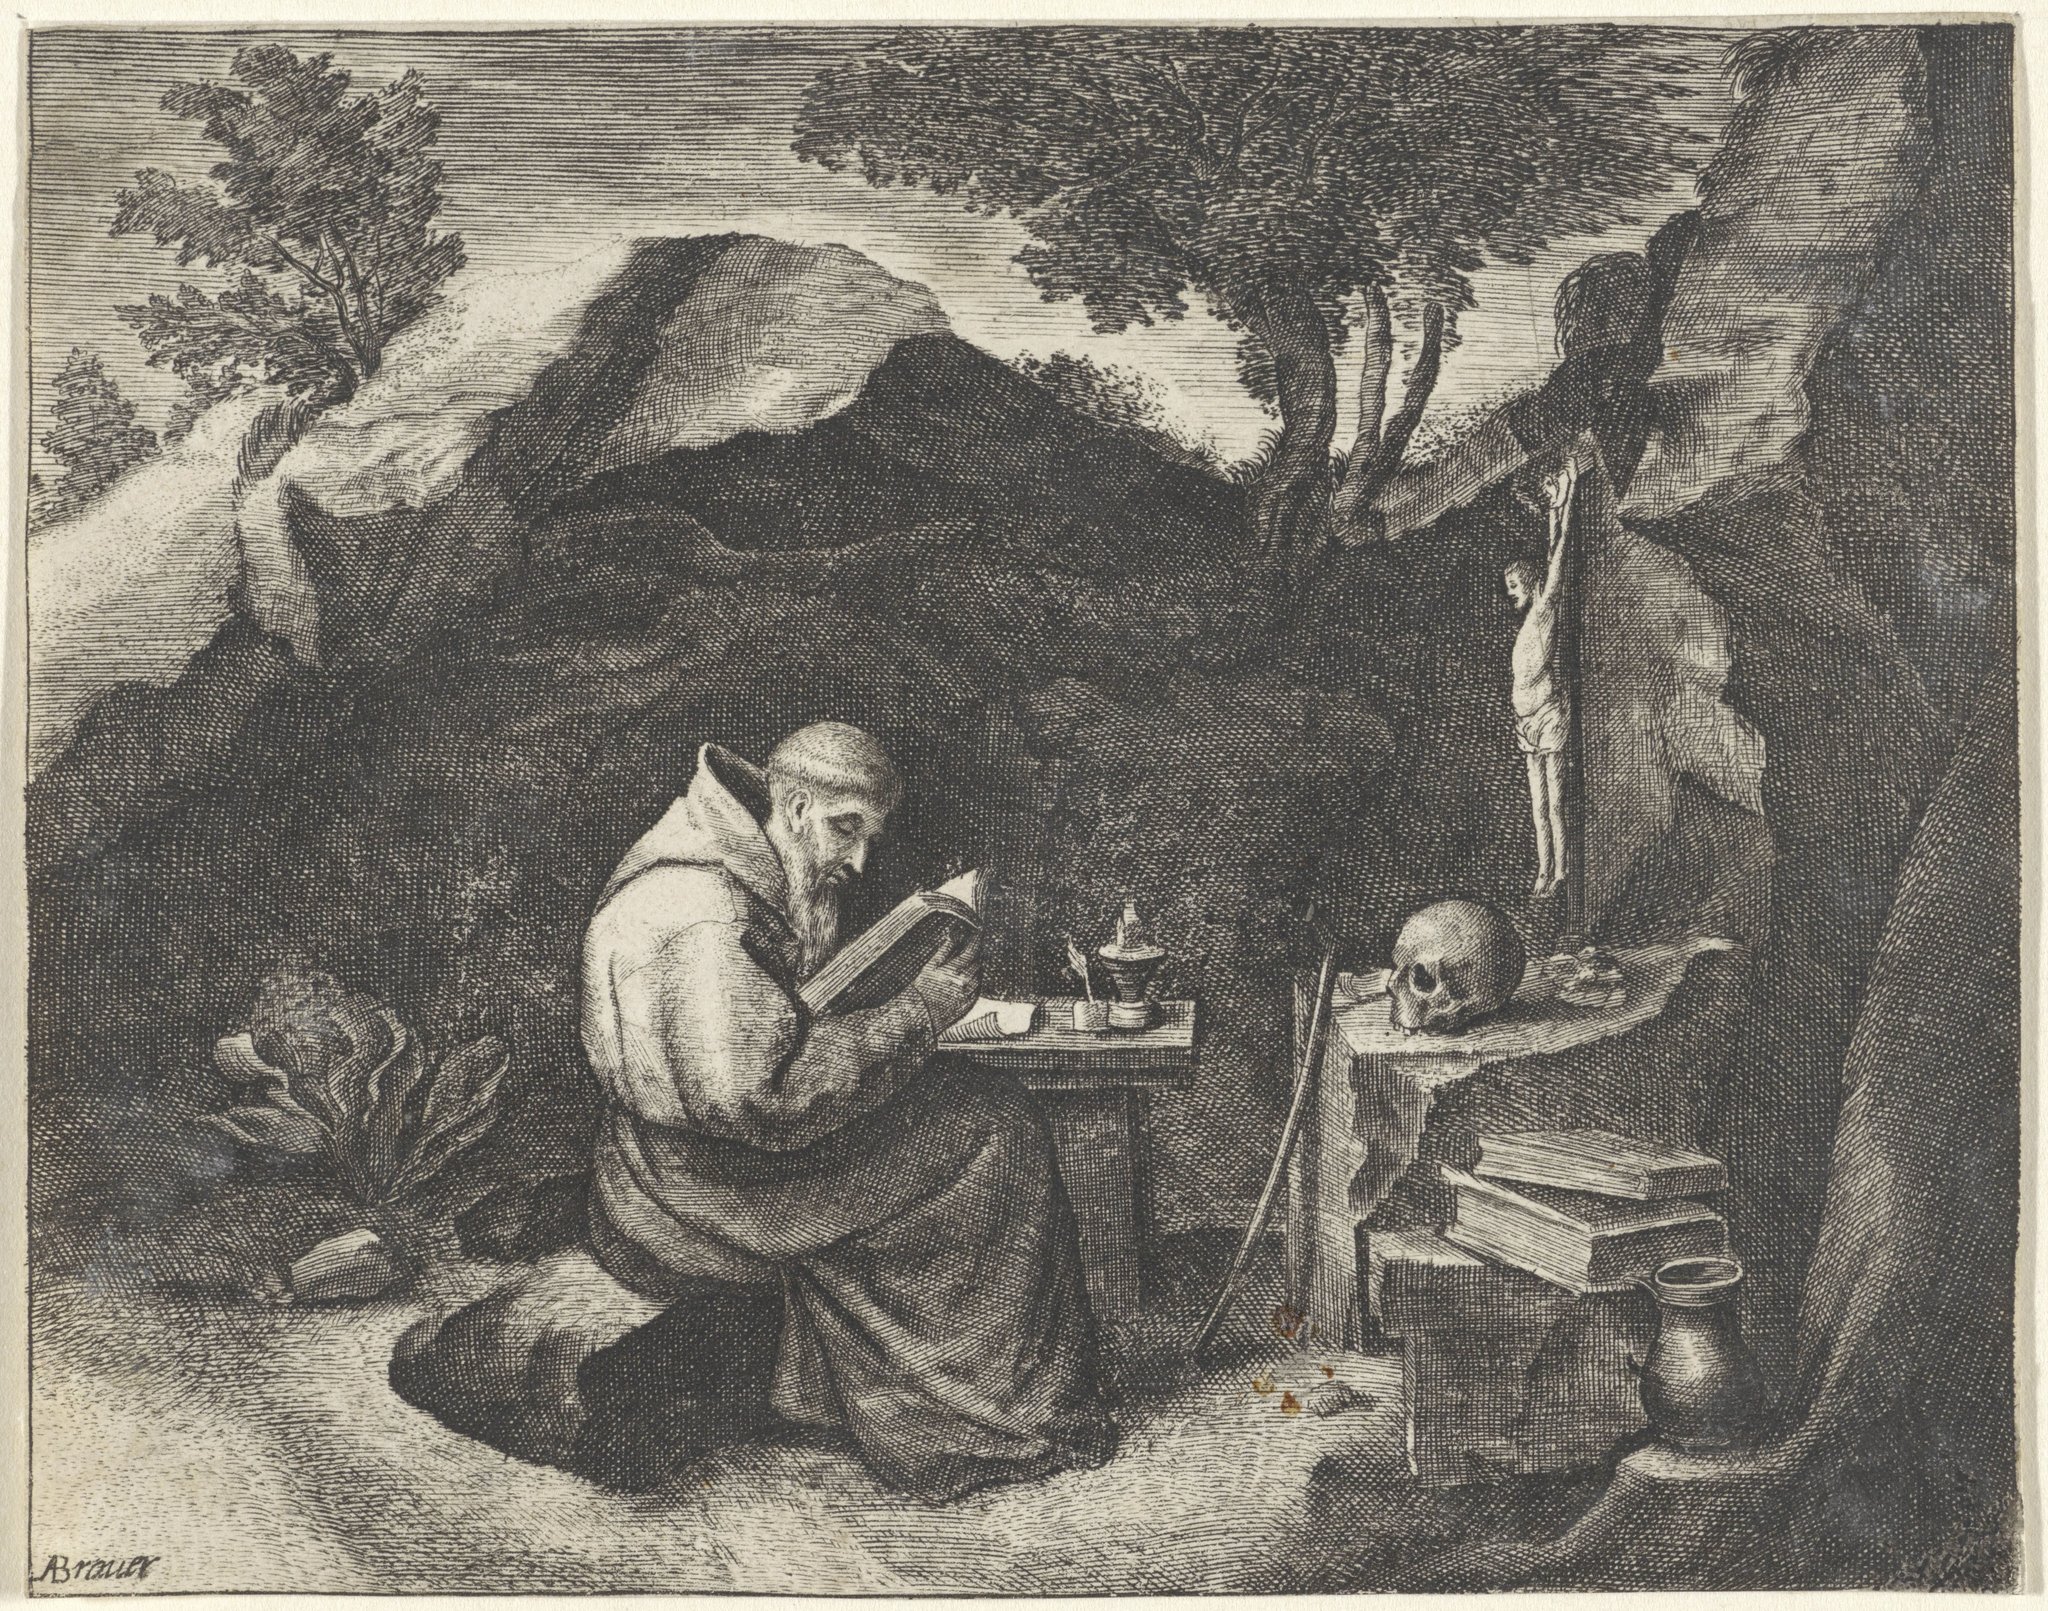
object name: print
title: H. Franciscus lezend in een grot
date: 1625-1727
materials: paper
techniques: etching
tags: personal devotion of st. francis of assisi - penitence of male saint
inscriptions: collector's mark: Lugt 240